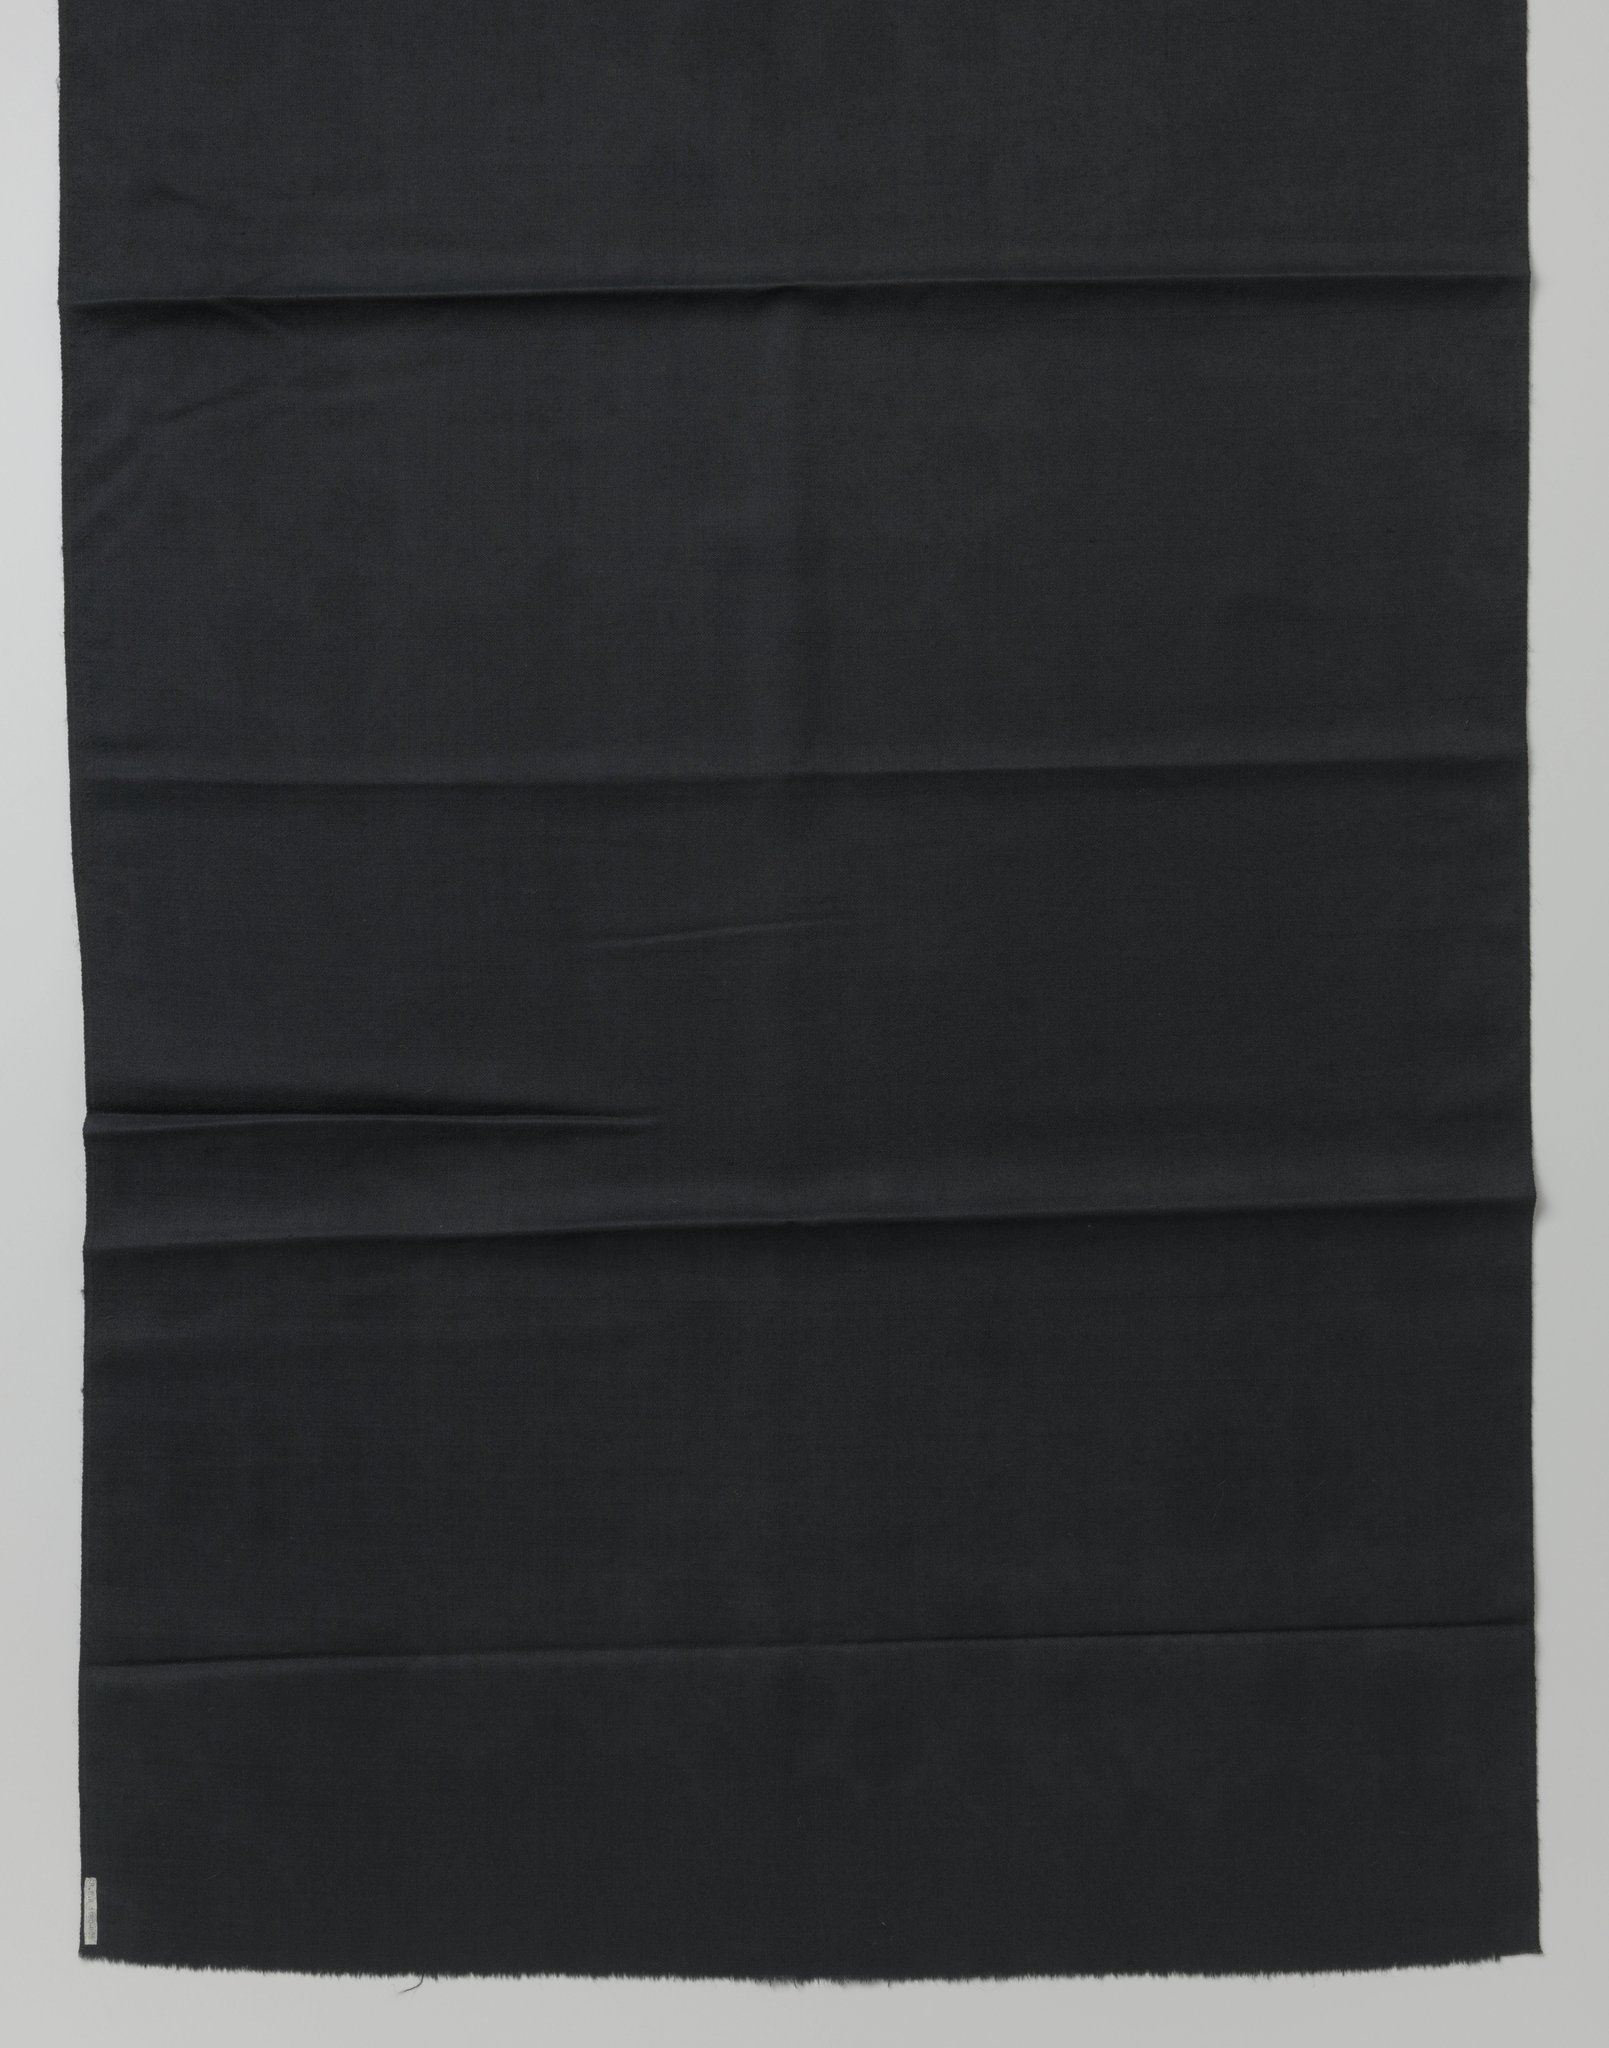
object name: rouwfloers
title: Fragment rouwfloers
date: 1875-1882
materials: wool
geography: netherlands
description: Fragment zwart rouwfloers van wol. Mogelijk gebruikt voor het afdekken van een raam.